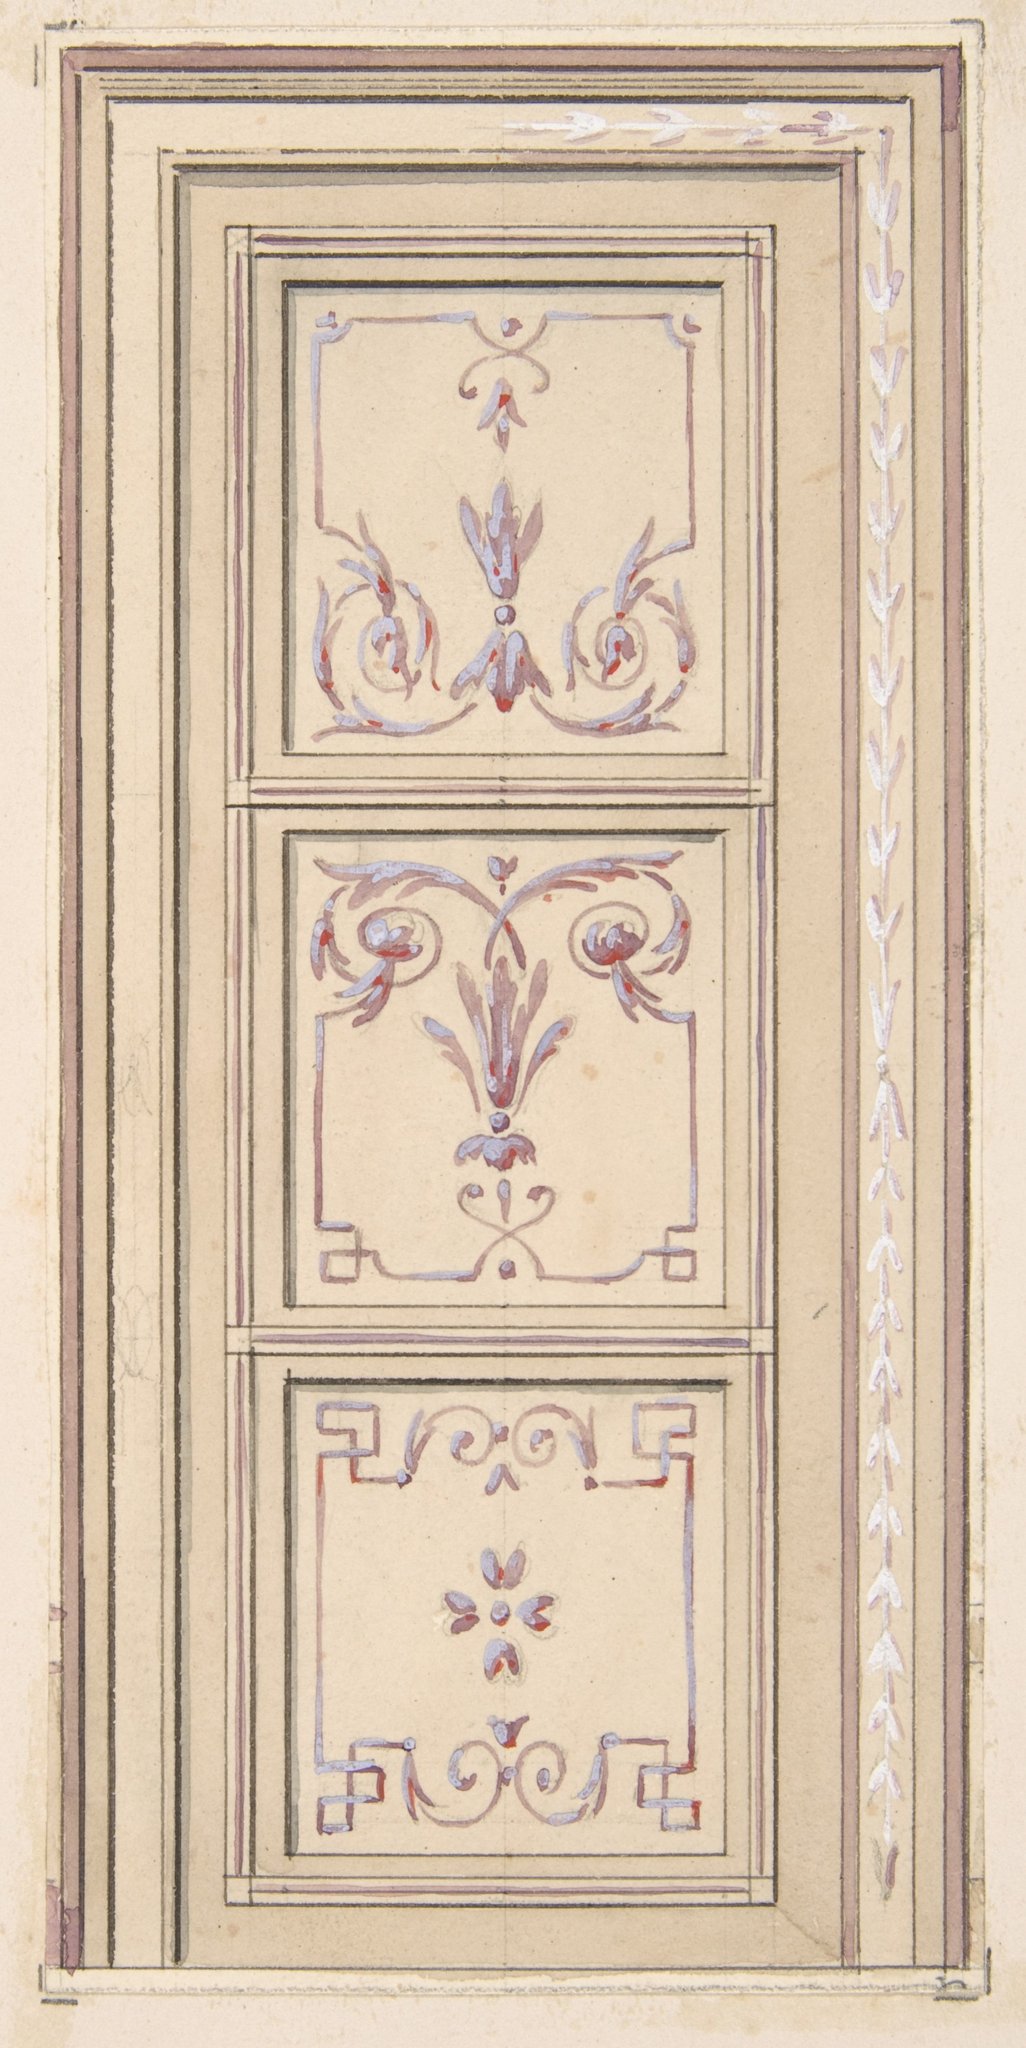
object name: drawing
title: Design for a ceiling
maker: jules-edmond-charles lachaise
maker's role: artist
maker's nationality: french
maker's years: 1897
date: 1851-1900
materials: gouache, graphite, watercolor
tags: architecture,ceilings